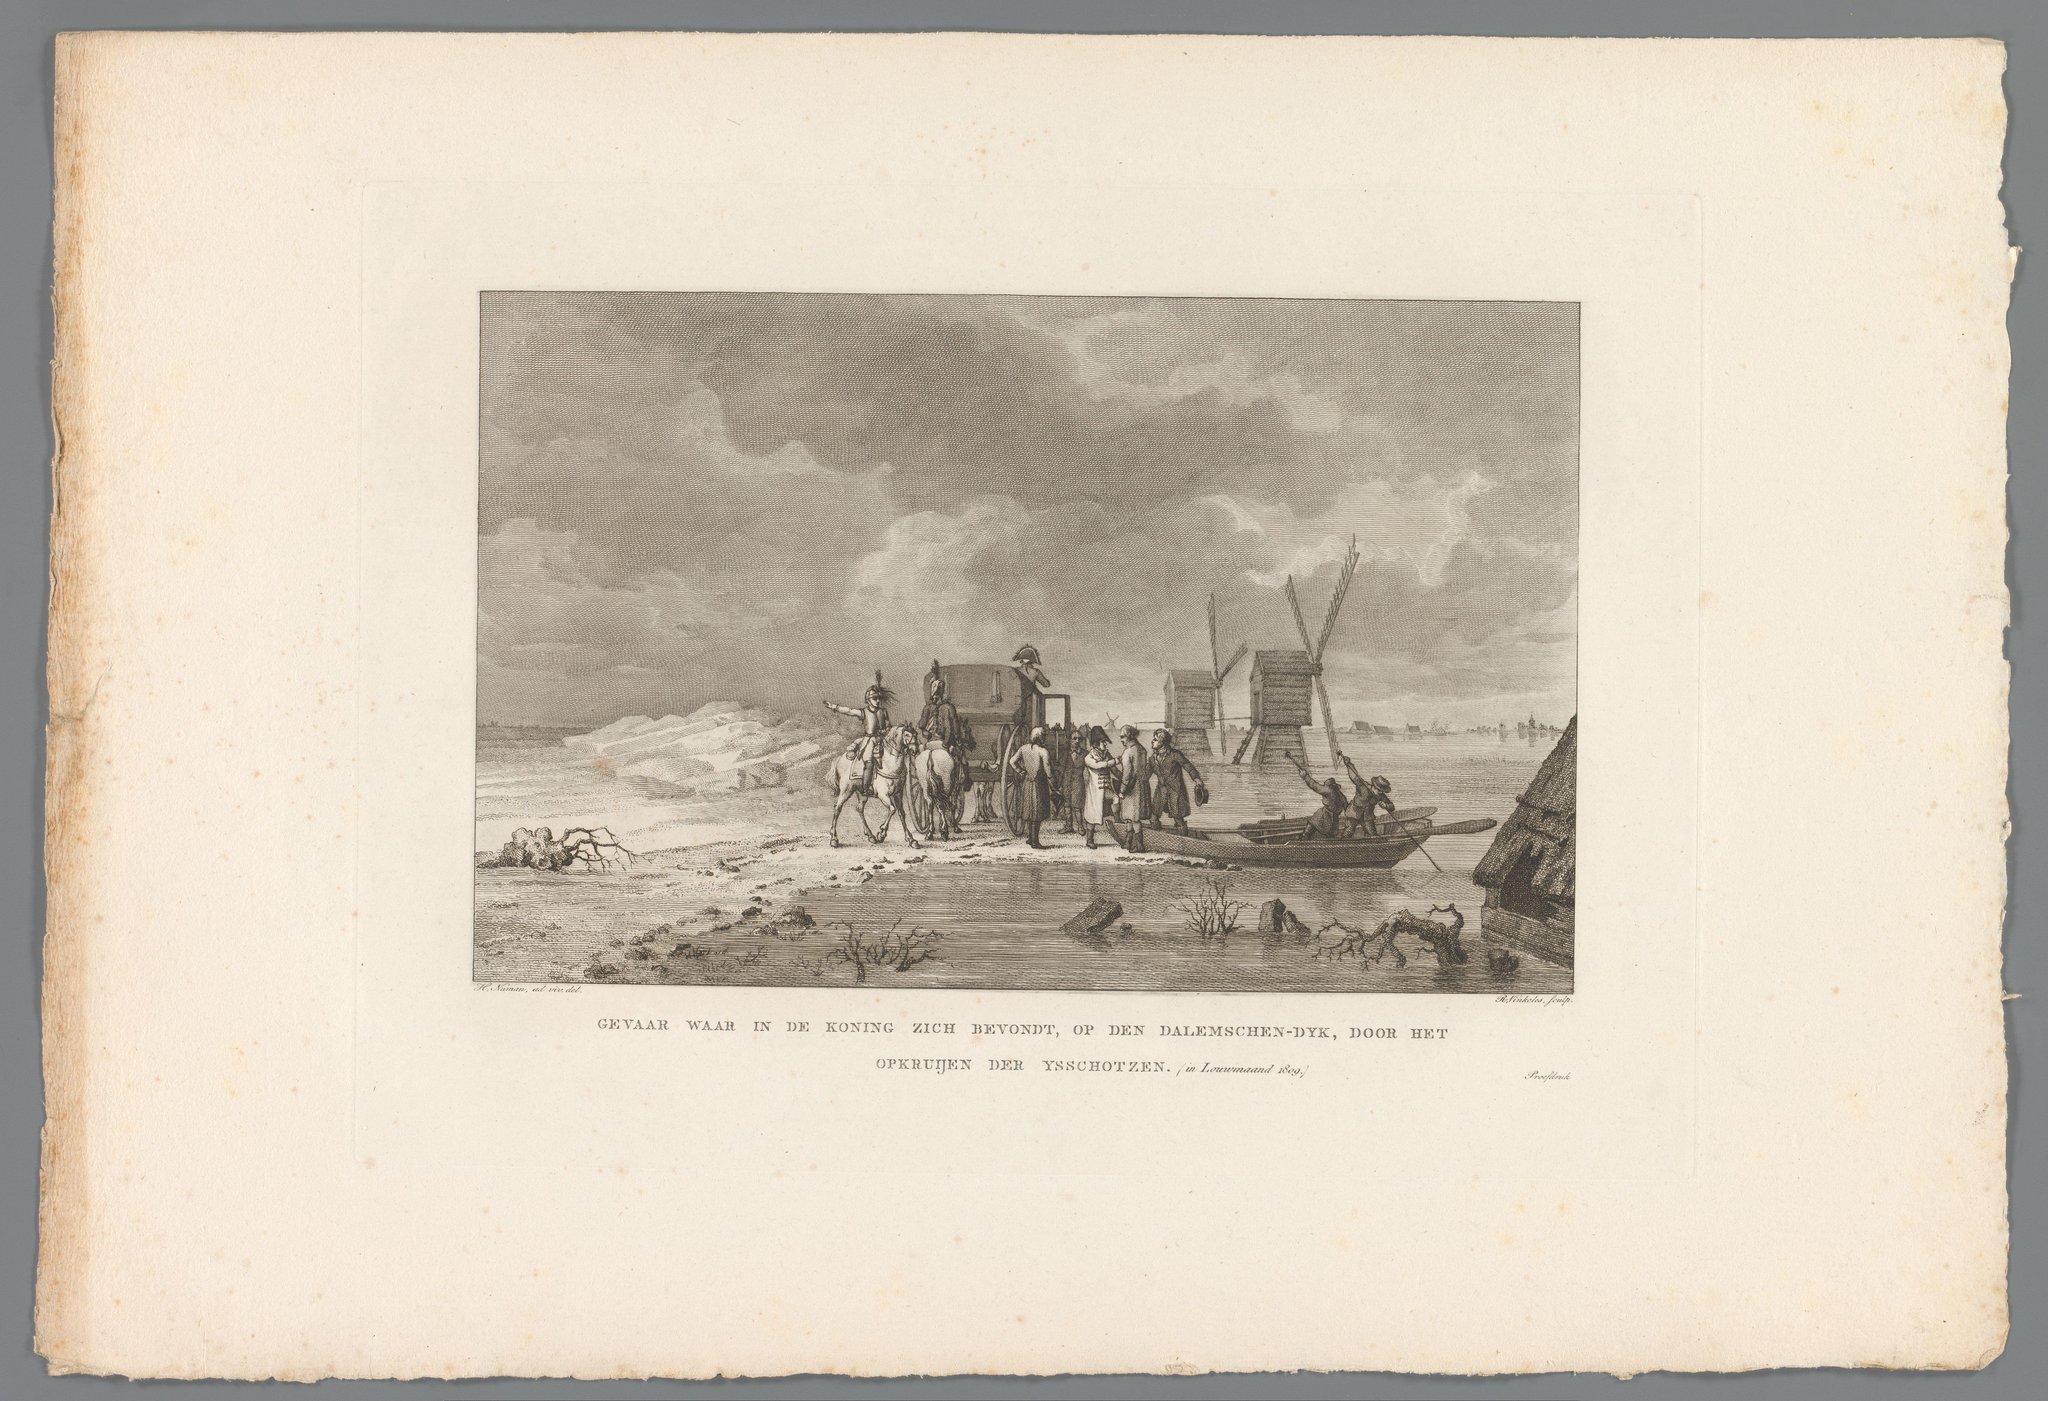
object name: print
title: Lodewijk Napoleon op de Dalemse dijk, 1809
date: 1809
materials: paper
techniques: engraving, etching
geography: amsterdam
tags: louis napoleon (king of holland), dike-break, four-wheeled, animal-drawn vehicle, e.g.: cab, carriage, coach, rowing-boat, canoe, etc., windmill, drift ice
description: Prent ook gebruikt ter illustratie van: Hendrik Ewijk. Geschiedkundig verslag der dijkbreuken en overstroomingen, langs de rivieren in het Koningrijk Holland, voorgevallen in louwmaand MDCCCIX. 3 dln. Amsterdam: Johannes Allart en Jacobus Ruys, 1809.